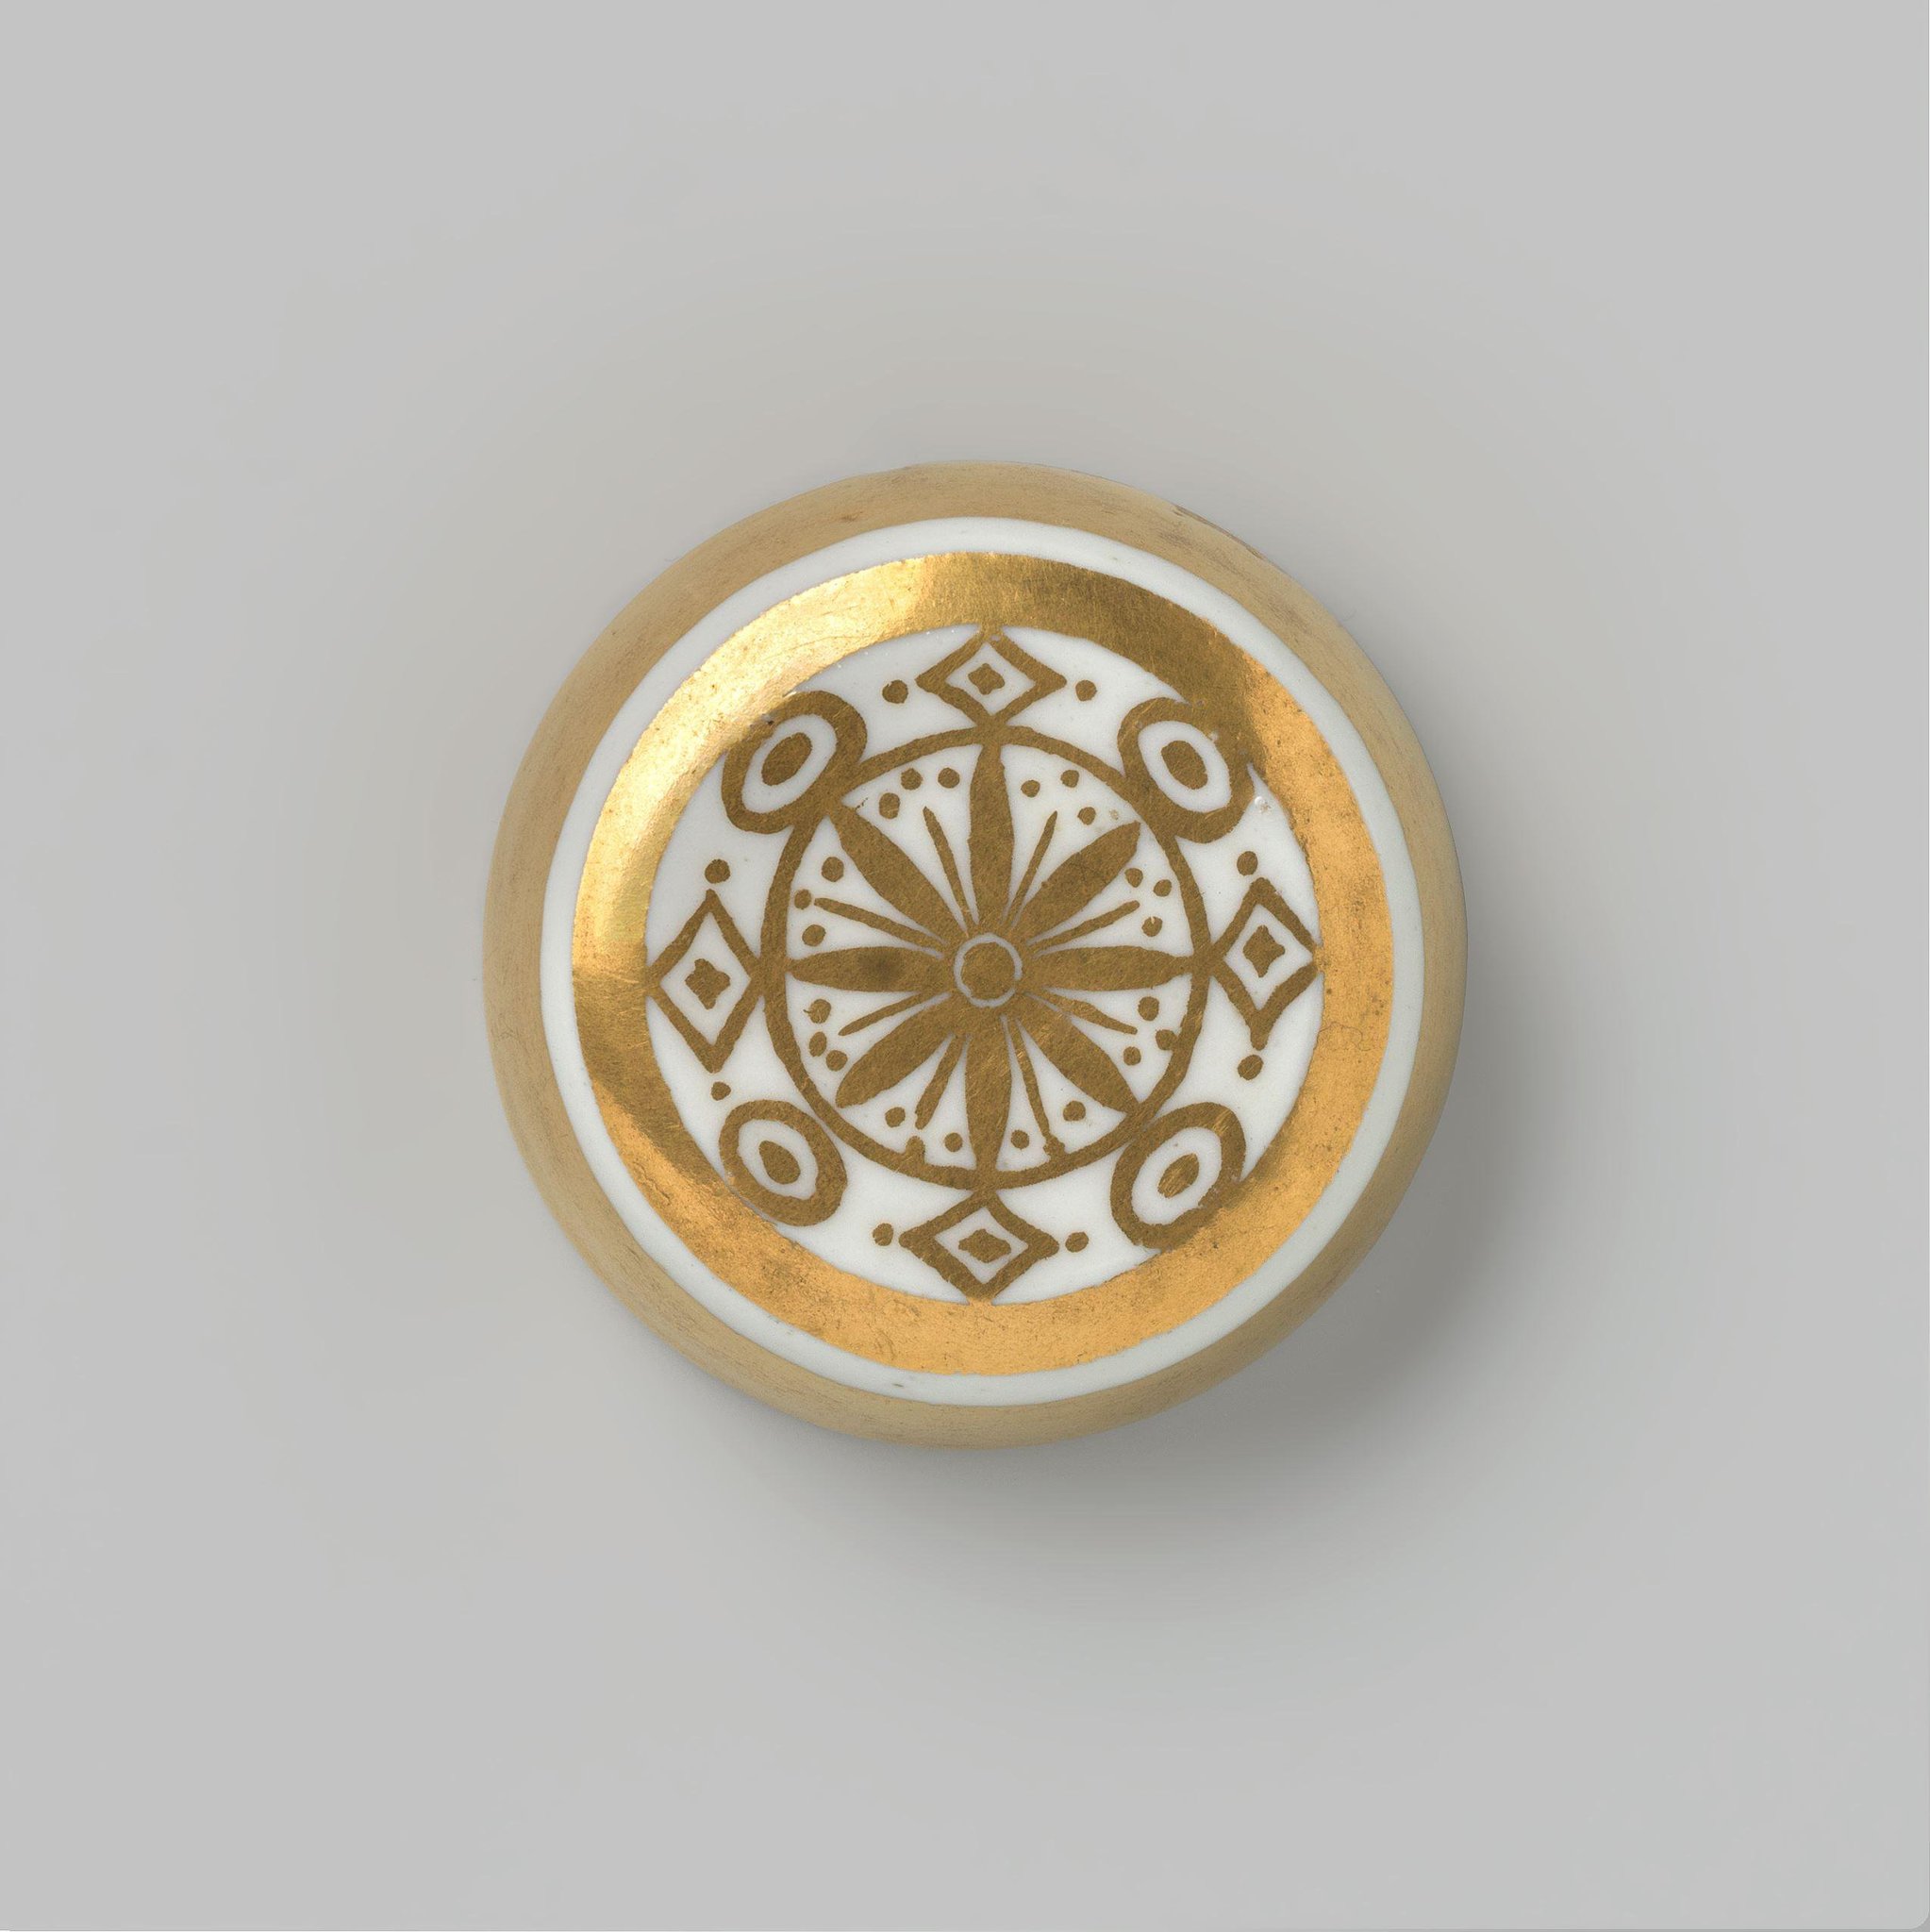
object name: lid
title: Deksel van theebus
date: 1725-1730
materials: porcelain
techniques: gilding, painted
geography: meissen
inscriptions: label: ‘B8’, number: ‘295’, number: ‘164.’, number: ‘NK.3011.A.’, number, number: ‘20.’, number: ‘0 [...] / OC(DLP)29-x-1953.b’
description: Dit object is van 1953 tot en met 2019 vanuit de Rijkscollectie ondergebracht geweest bij Museum Boijmans van Beuningen in Rotterdam. Een theekop en schotel uit dit servies zat in de collectie Anrhold, verworven door Lisa en Heinrich Arnhold in 1927 van M. Salomon in Dresden, geïllustreerd in Cassidy-Geiger, 2008, p. 302, cat. nr. 76 (veiling catalogus, Sotheby’s New York, 14 september 2021, nr. 68, p. 186).